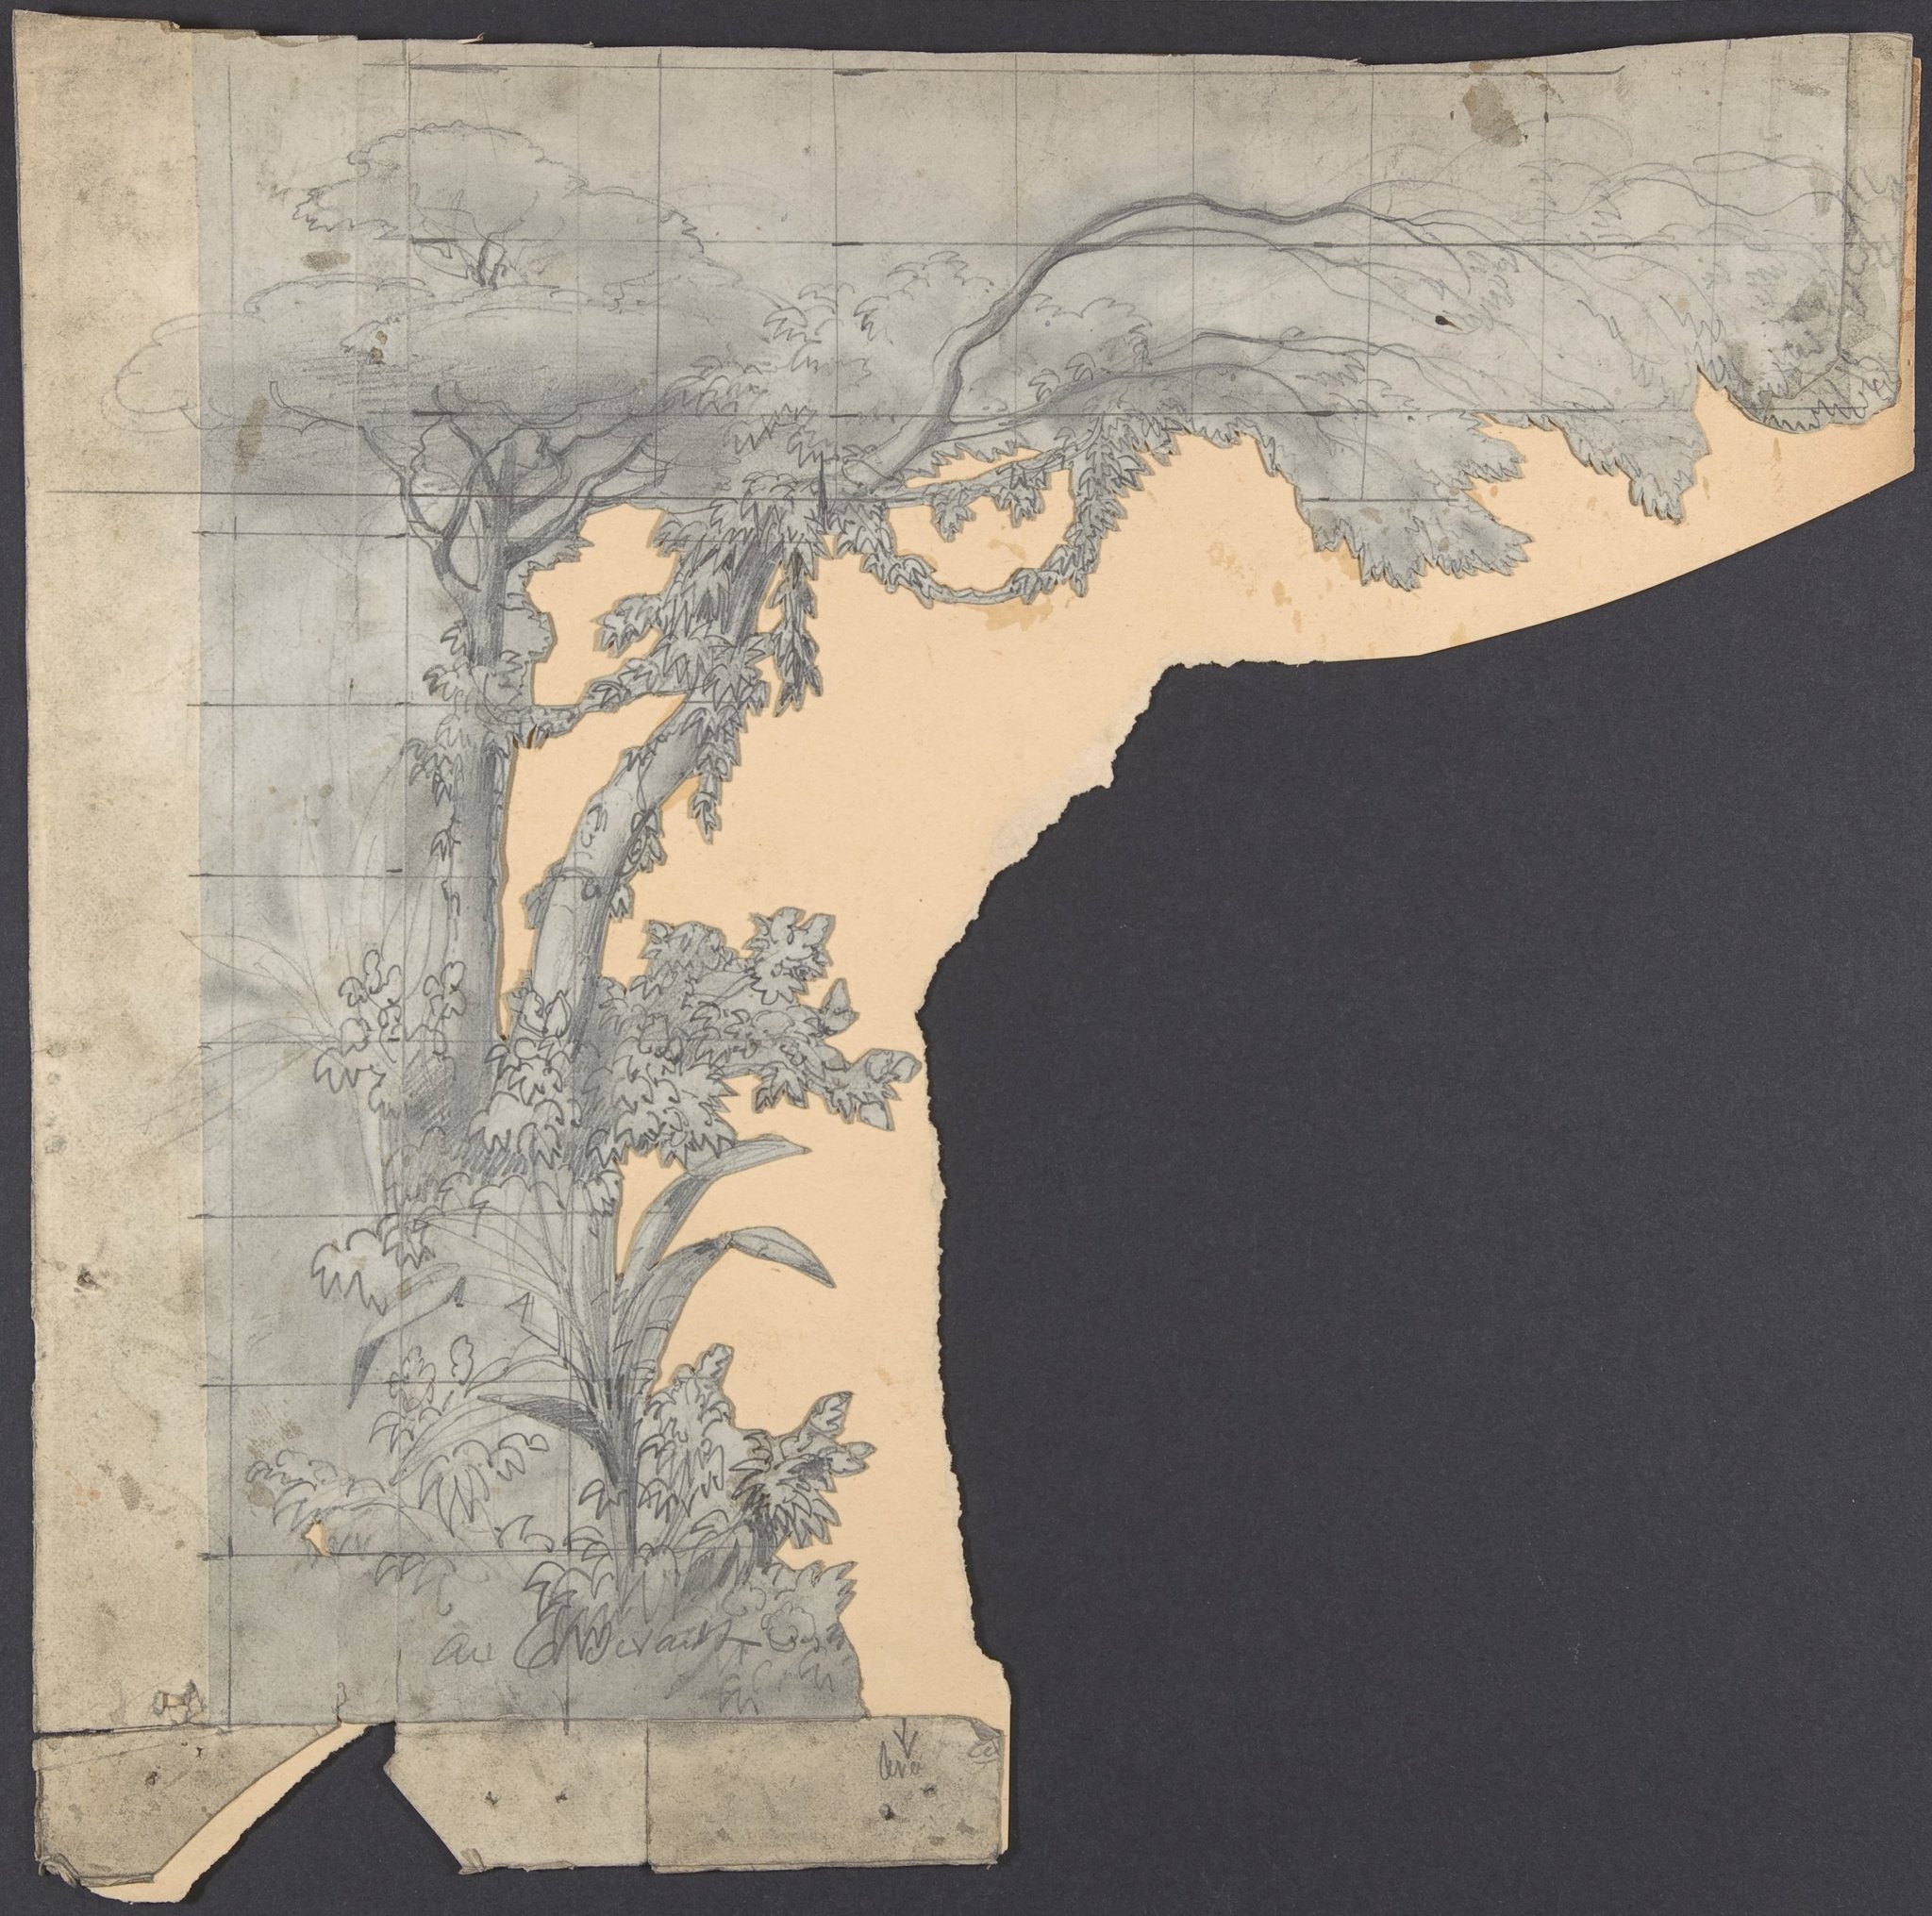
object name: drawing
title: Design for a Stage Set at the Opéra, Paris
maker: eugène cicéri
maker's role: artist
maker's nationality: french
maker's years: 1813-1890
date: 1830-1890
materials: graphite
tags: trees,stage design